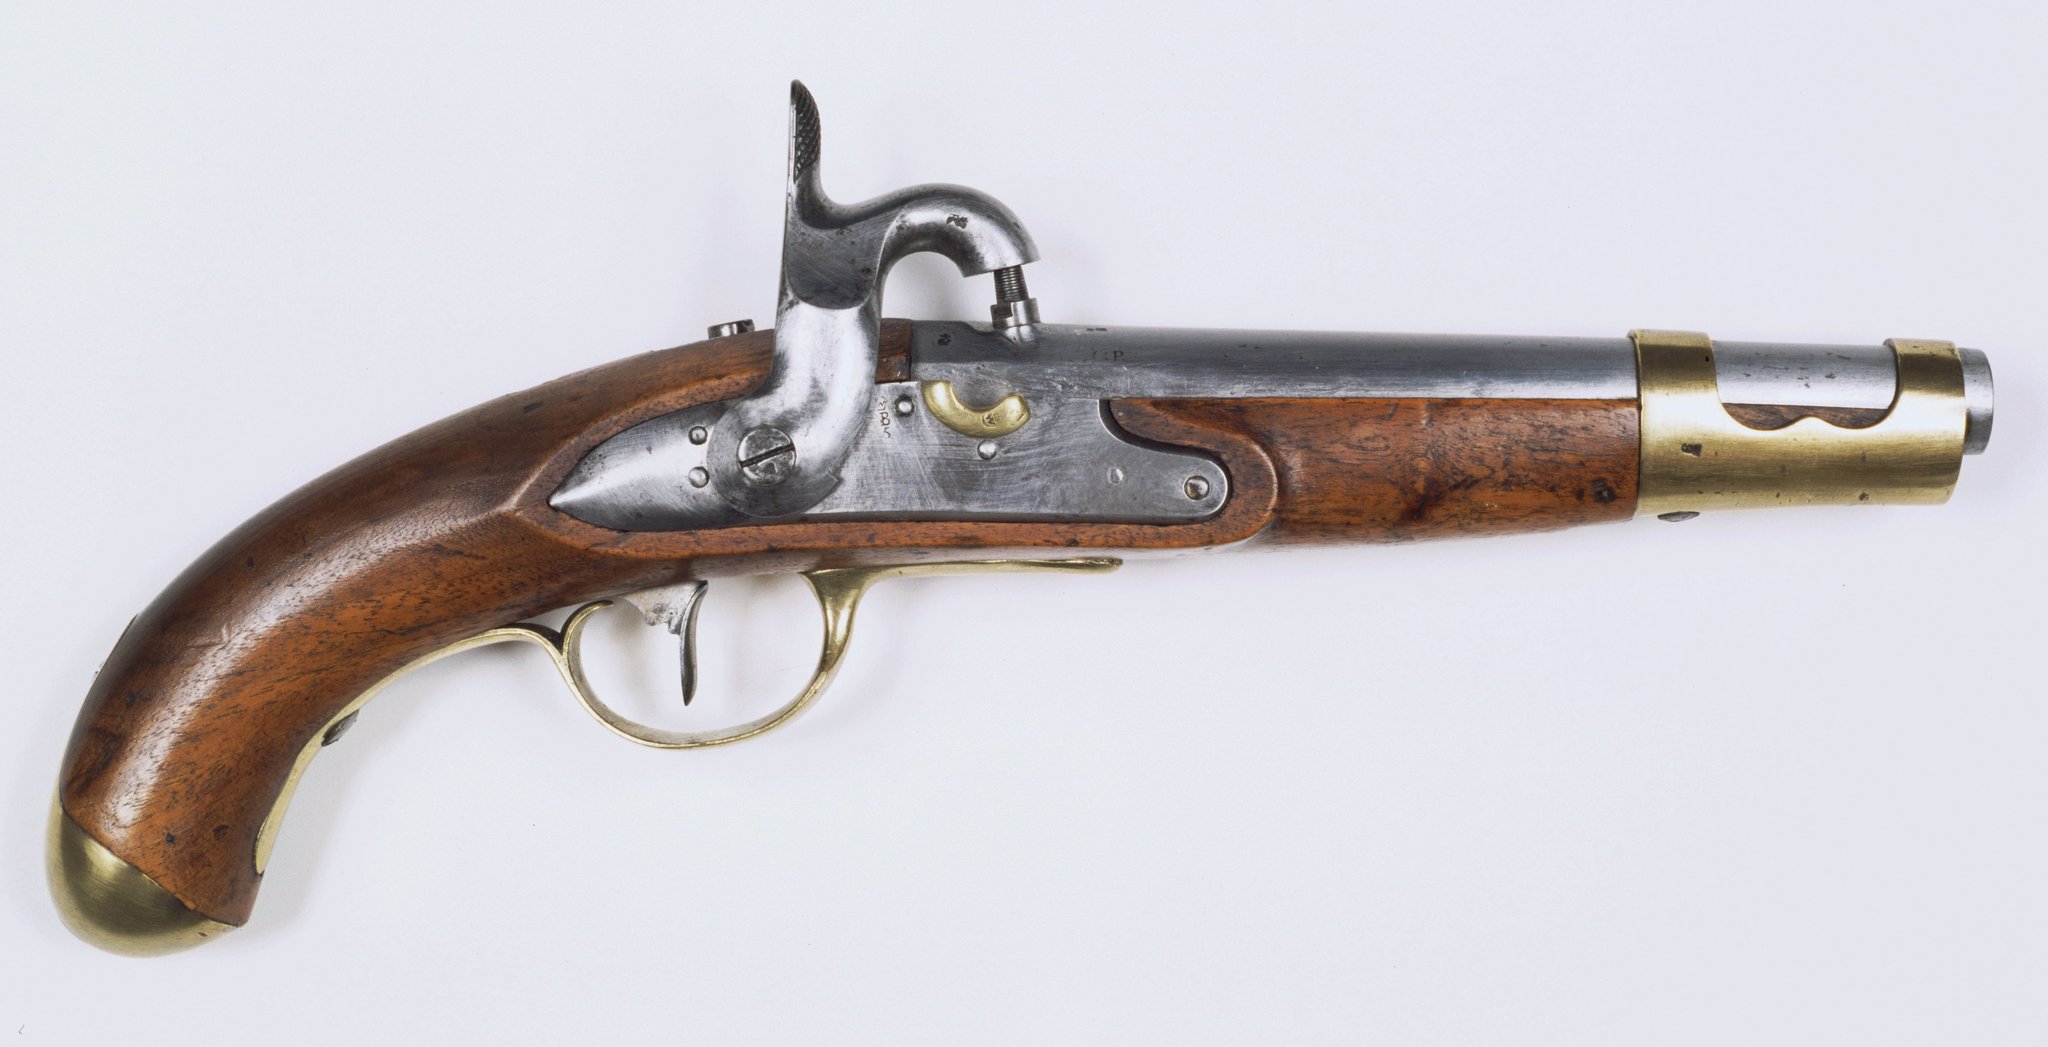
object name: percussion pistol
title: Percussie legerpistool model M 1815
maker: Anonymous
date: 1815-1816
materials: brass, iron, wood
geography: netherlands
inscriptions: signature: ‘B met kroon’, signature: ‘K met kroon’, signature: ‘W met kroon’, signature: ‘IS met kroon’